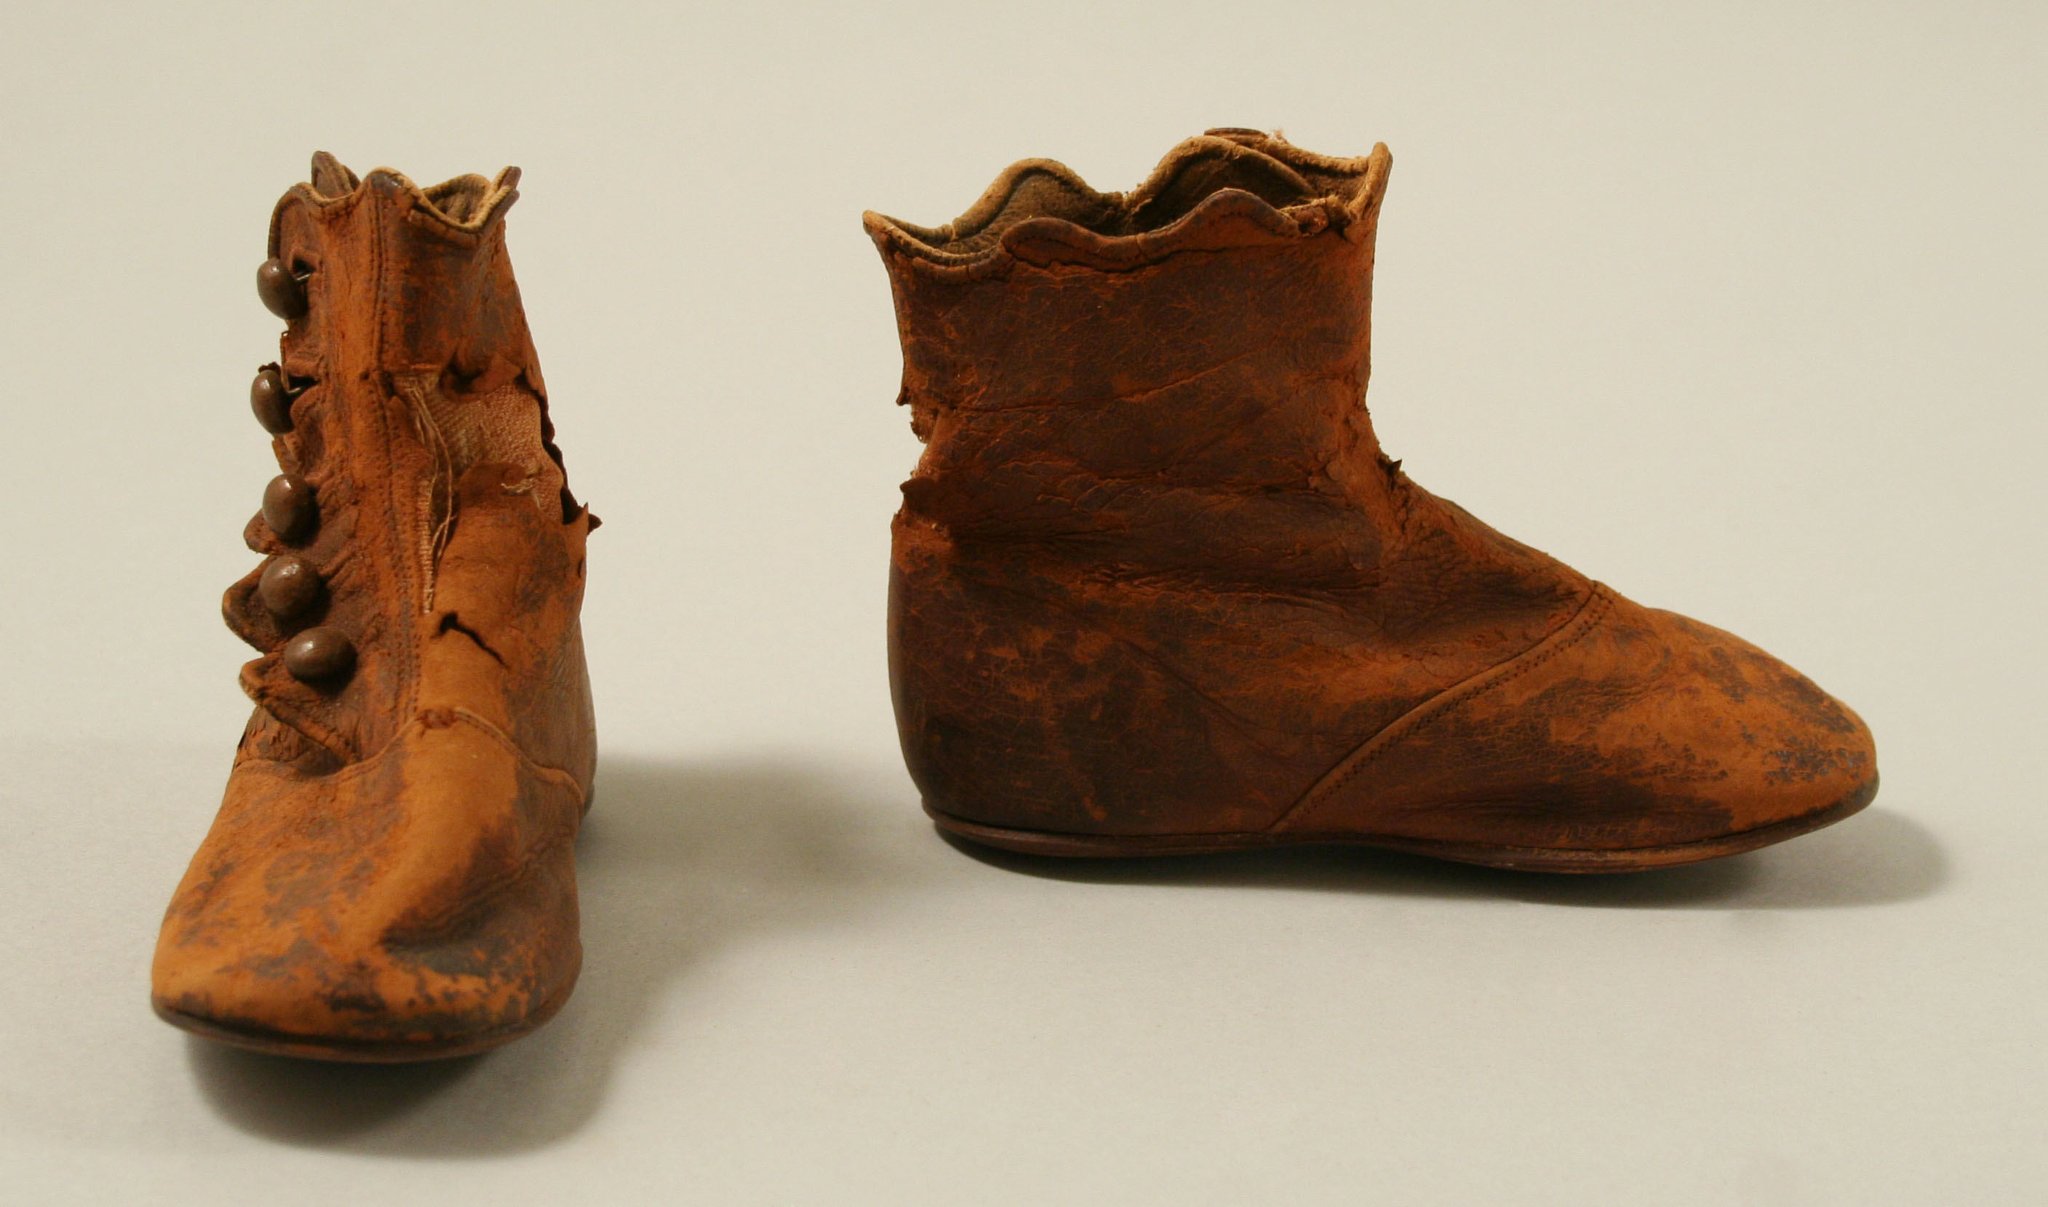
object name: boot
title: Boots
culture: american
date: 1800-1940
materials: leather